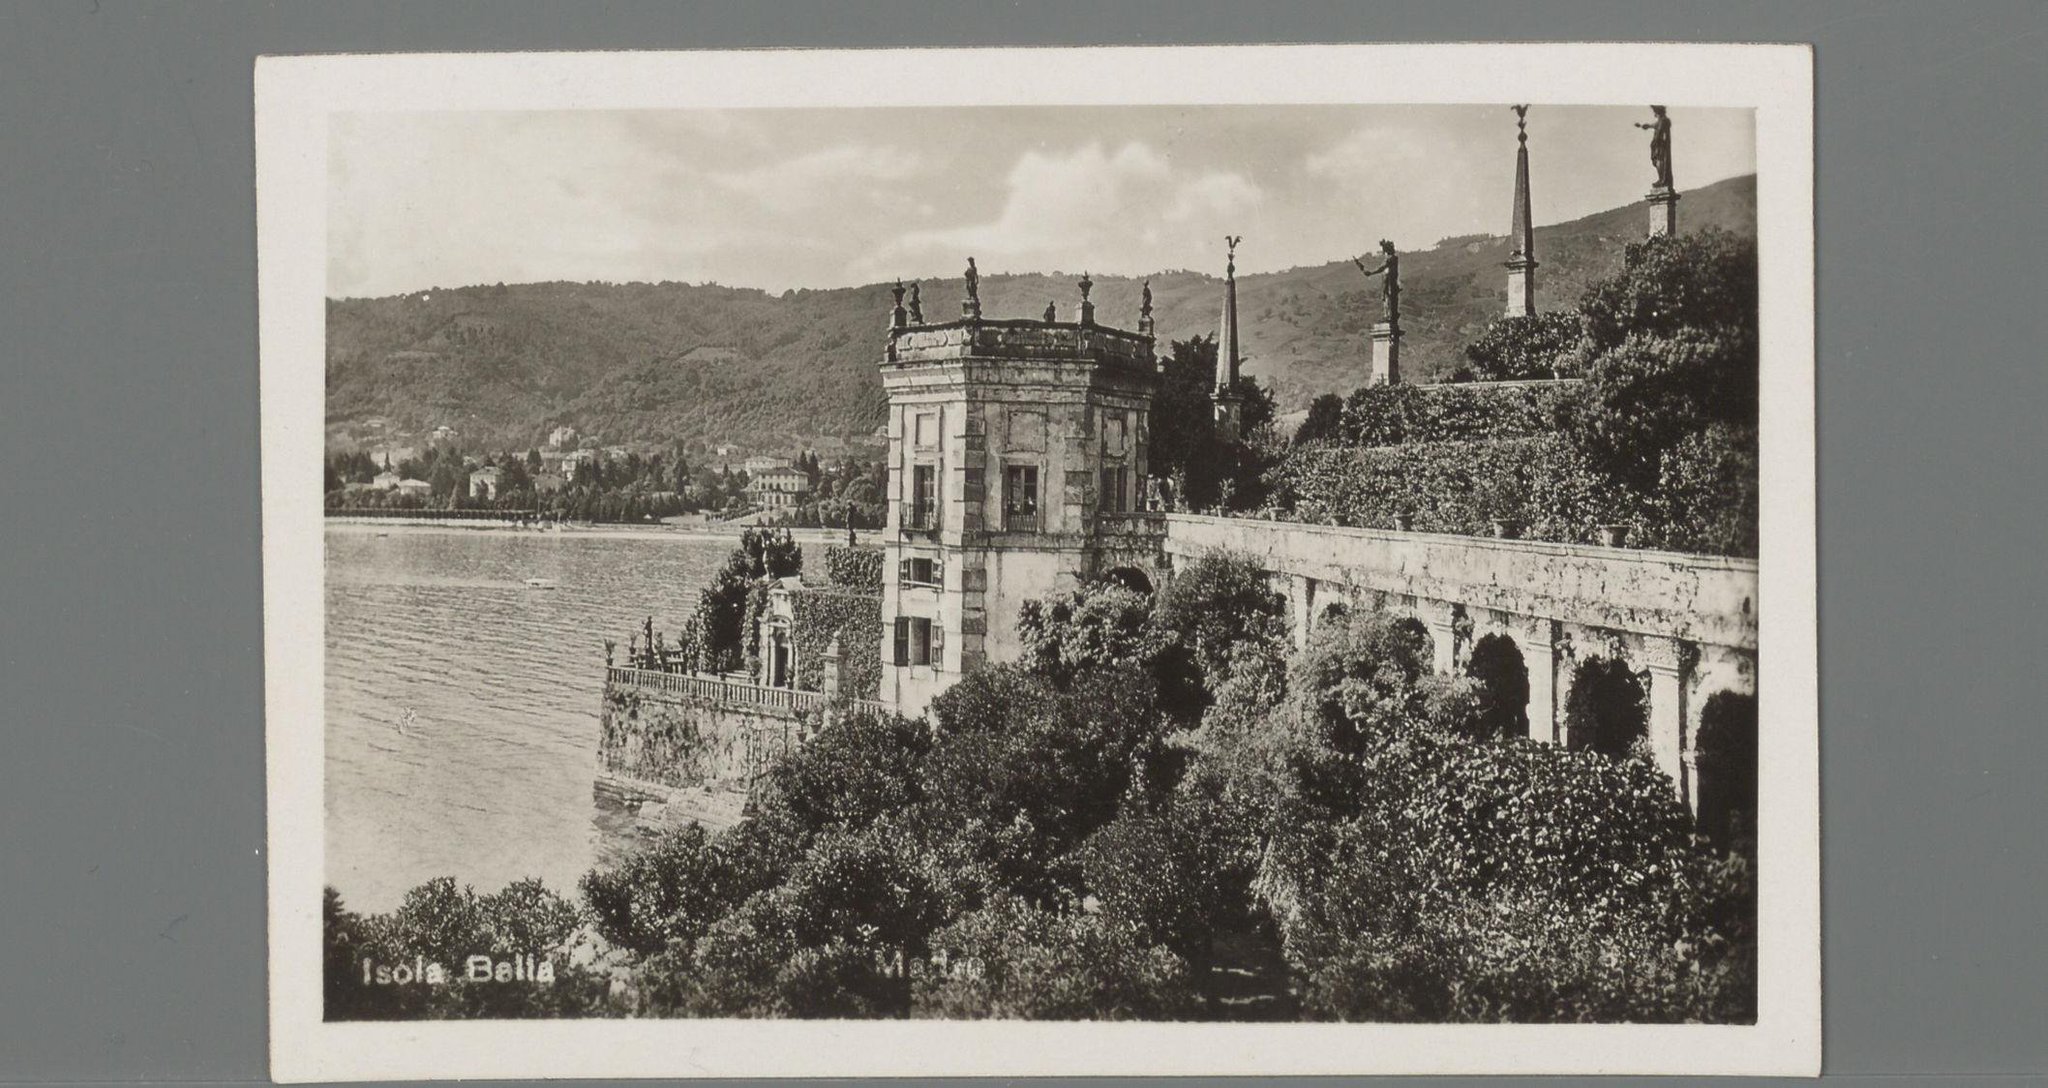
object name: photograph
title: Pallanza ed Isole Borromee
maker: Anonymous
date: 1904-1935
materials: photographic support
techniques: photography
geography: como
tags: lake, public gardens, park